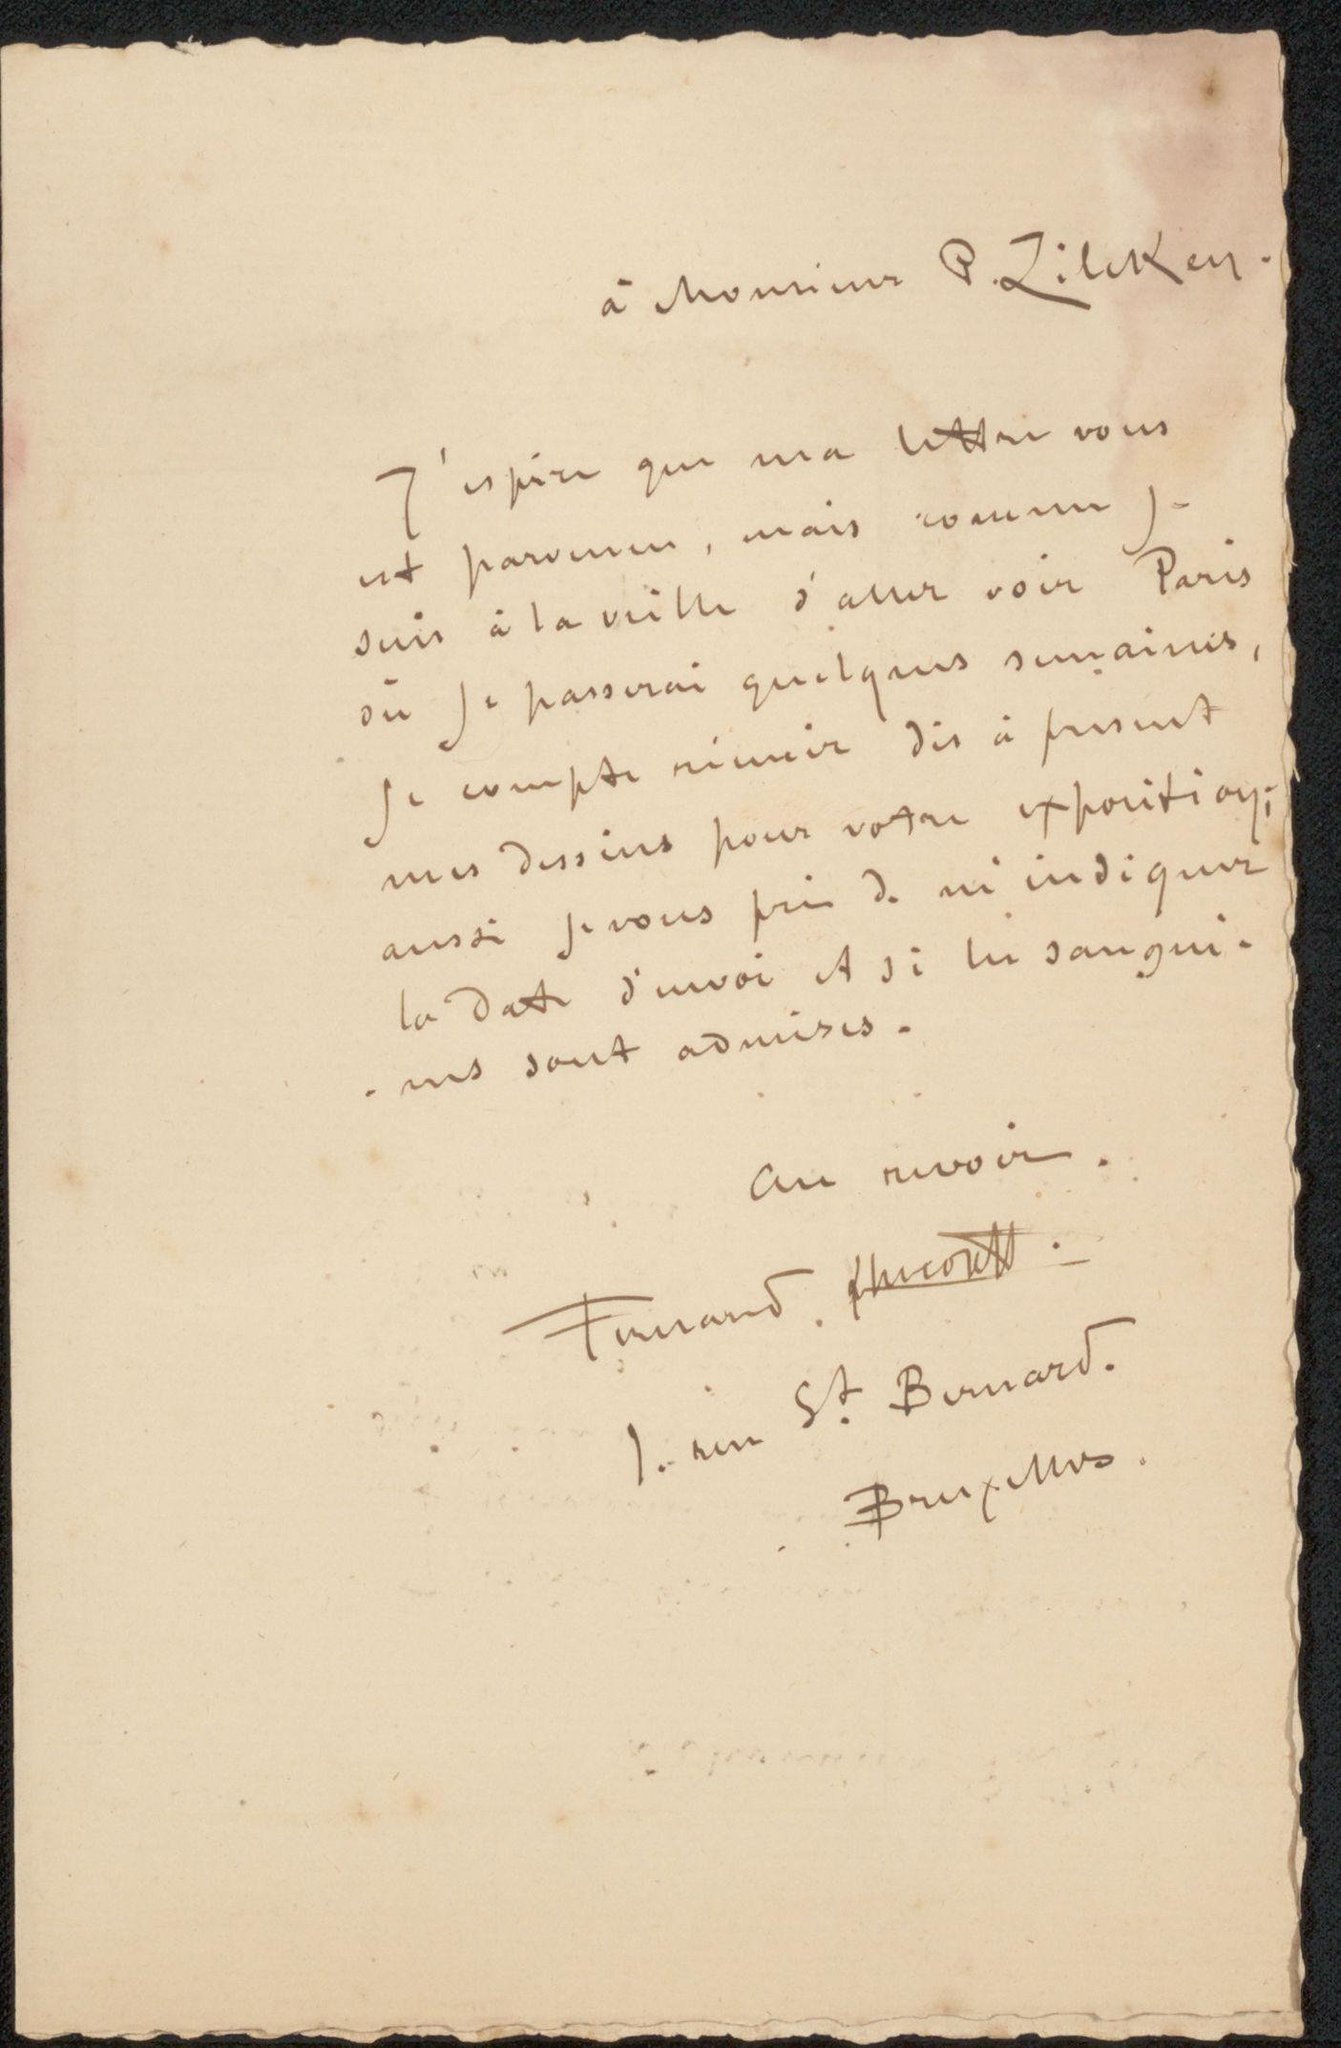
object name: letter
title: Brief aan Philip Zilcken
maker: fernand khnopff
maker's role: draughtsman, print maker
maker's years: 1858-1921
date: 1868-1921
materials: ink, paper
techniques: pen, writing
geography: brussels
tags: the hague, philip zilcken, drawing, exhibition ~ art, paris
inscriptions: collector's mark: ‘RPK’